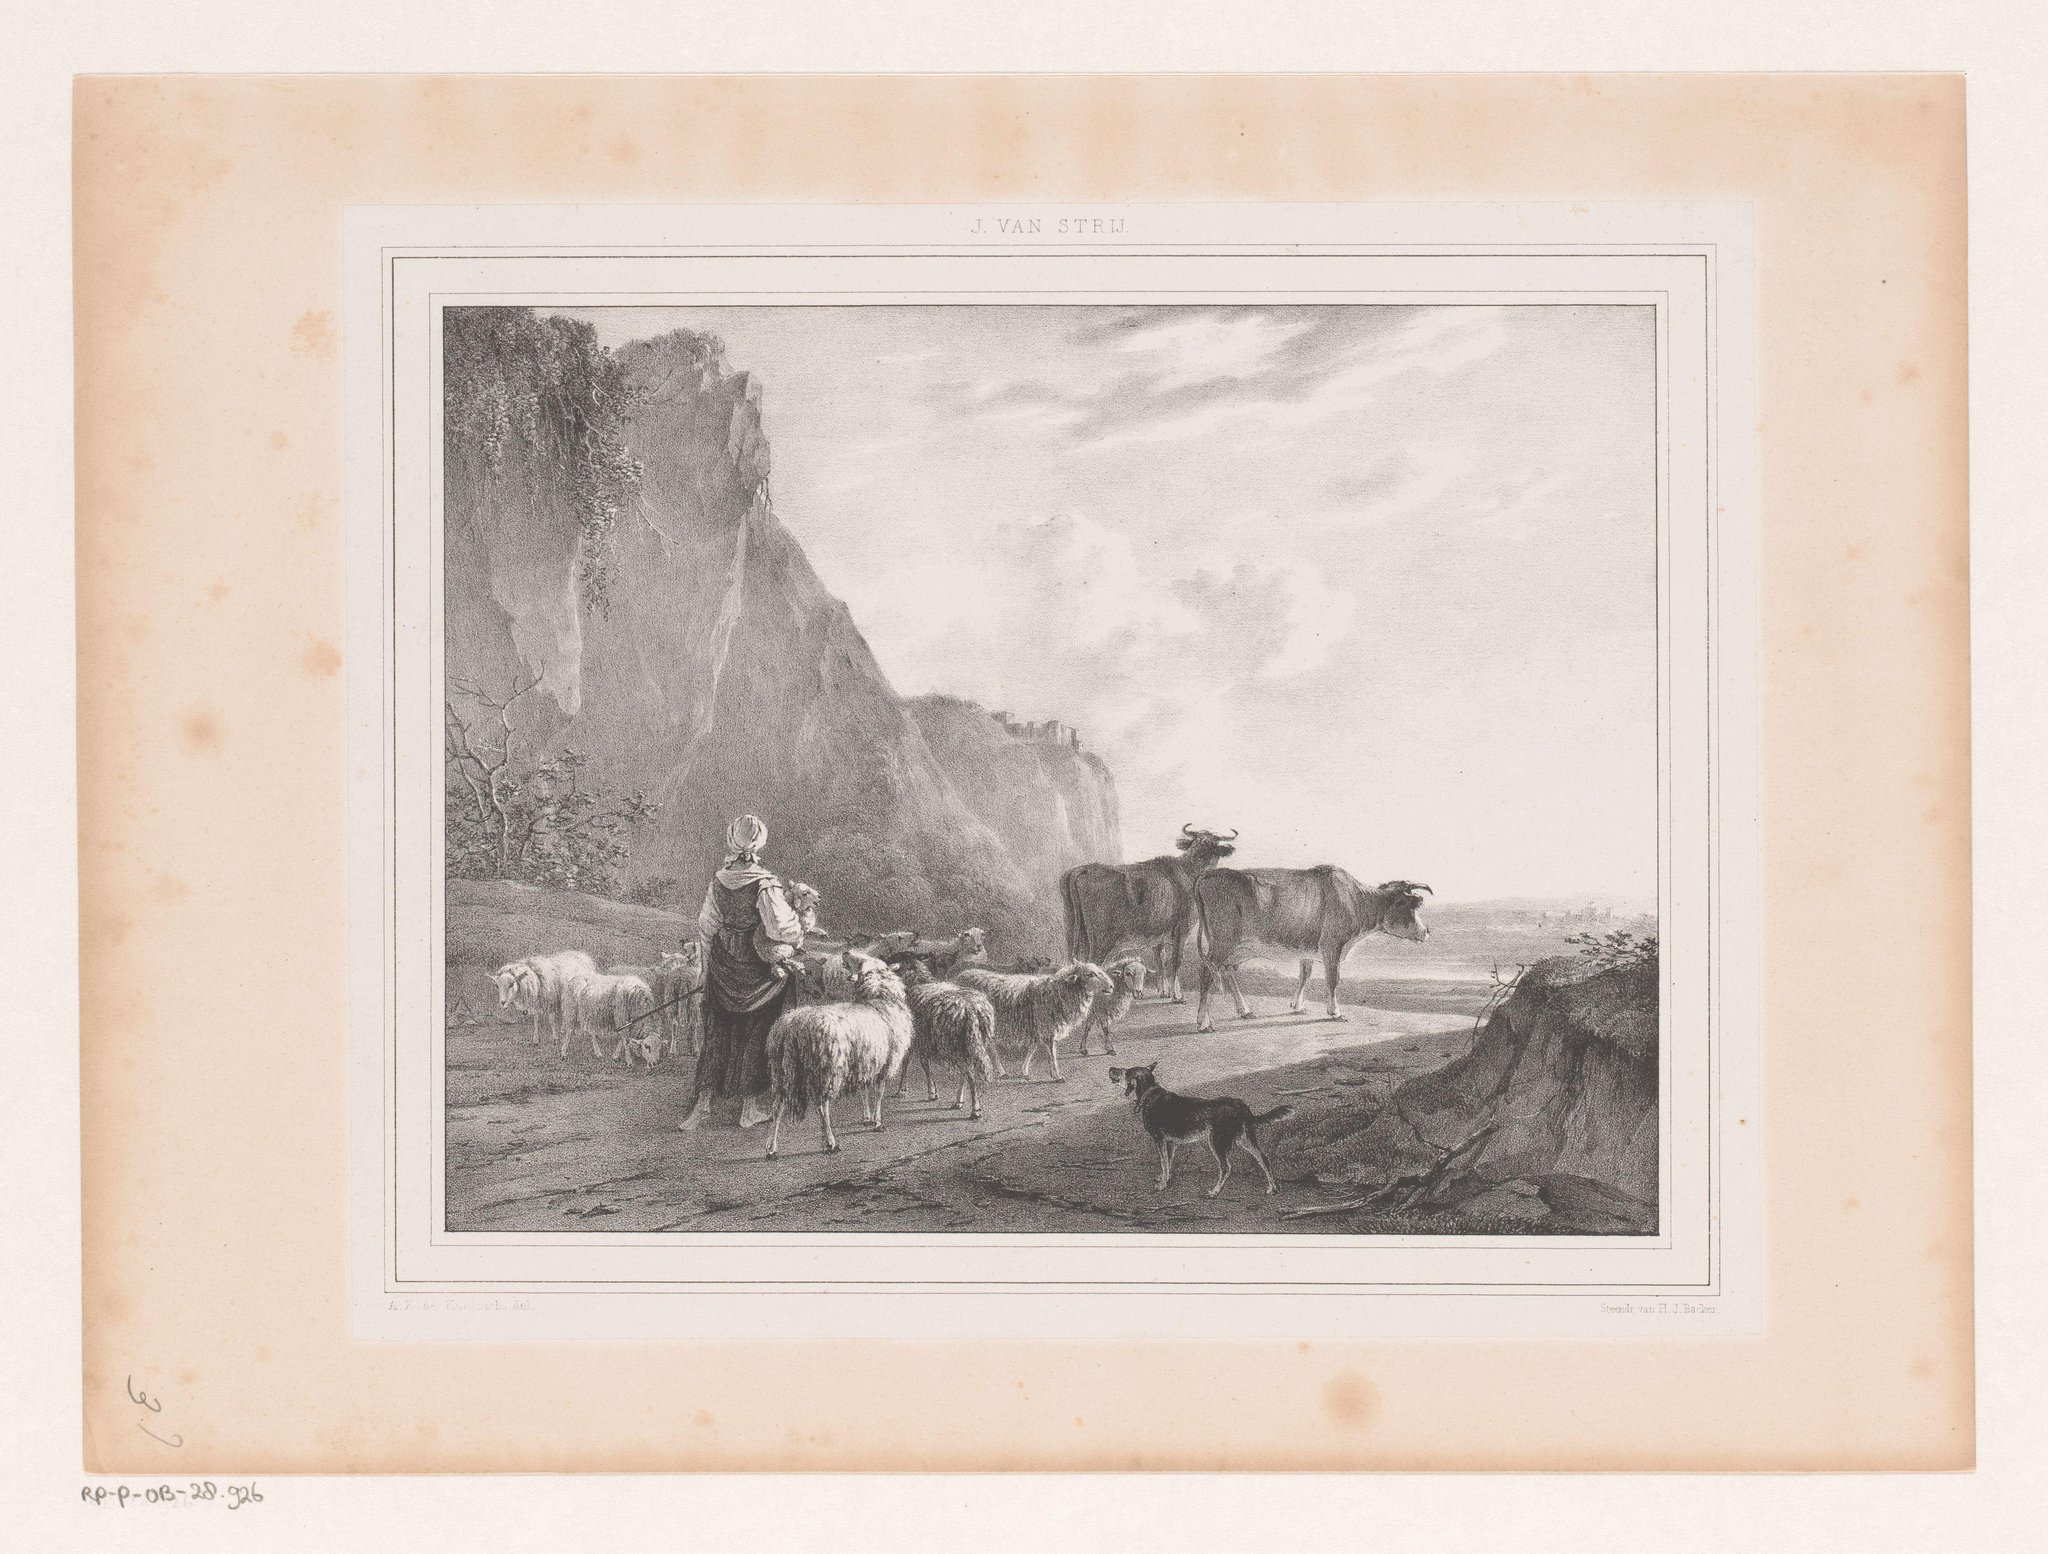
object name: print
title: Landschap met kudde en herderin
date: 1822-1845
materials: paper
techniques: lithograph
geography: dordrecht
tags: cow, herding, herdsman, herdswoman, shepherd, shepherdess, cowherd, etc., cattle driving, cattle driver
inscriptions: collector's mark: Lugt 2228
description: De herderin heeft een lam onder haar arm. De kudde bestaat uit schapen en koeien.